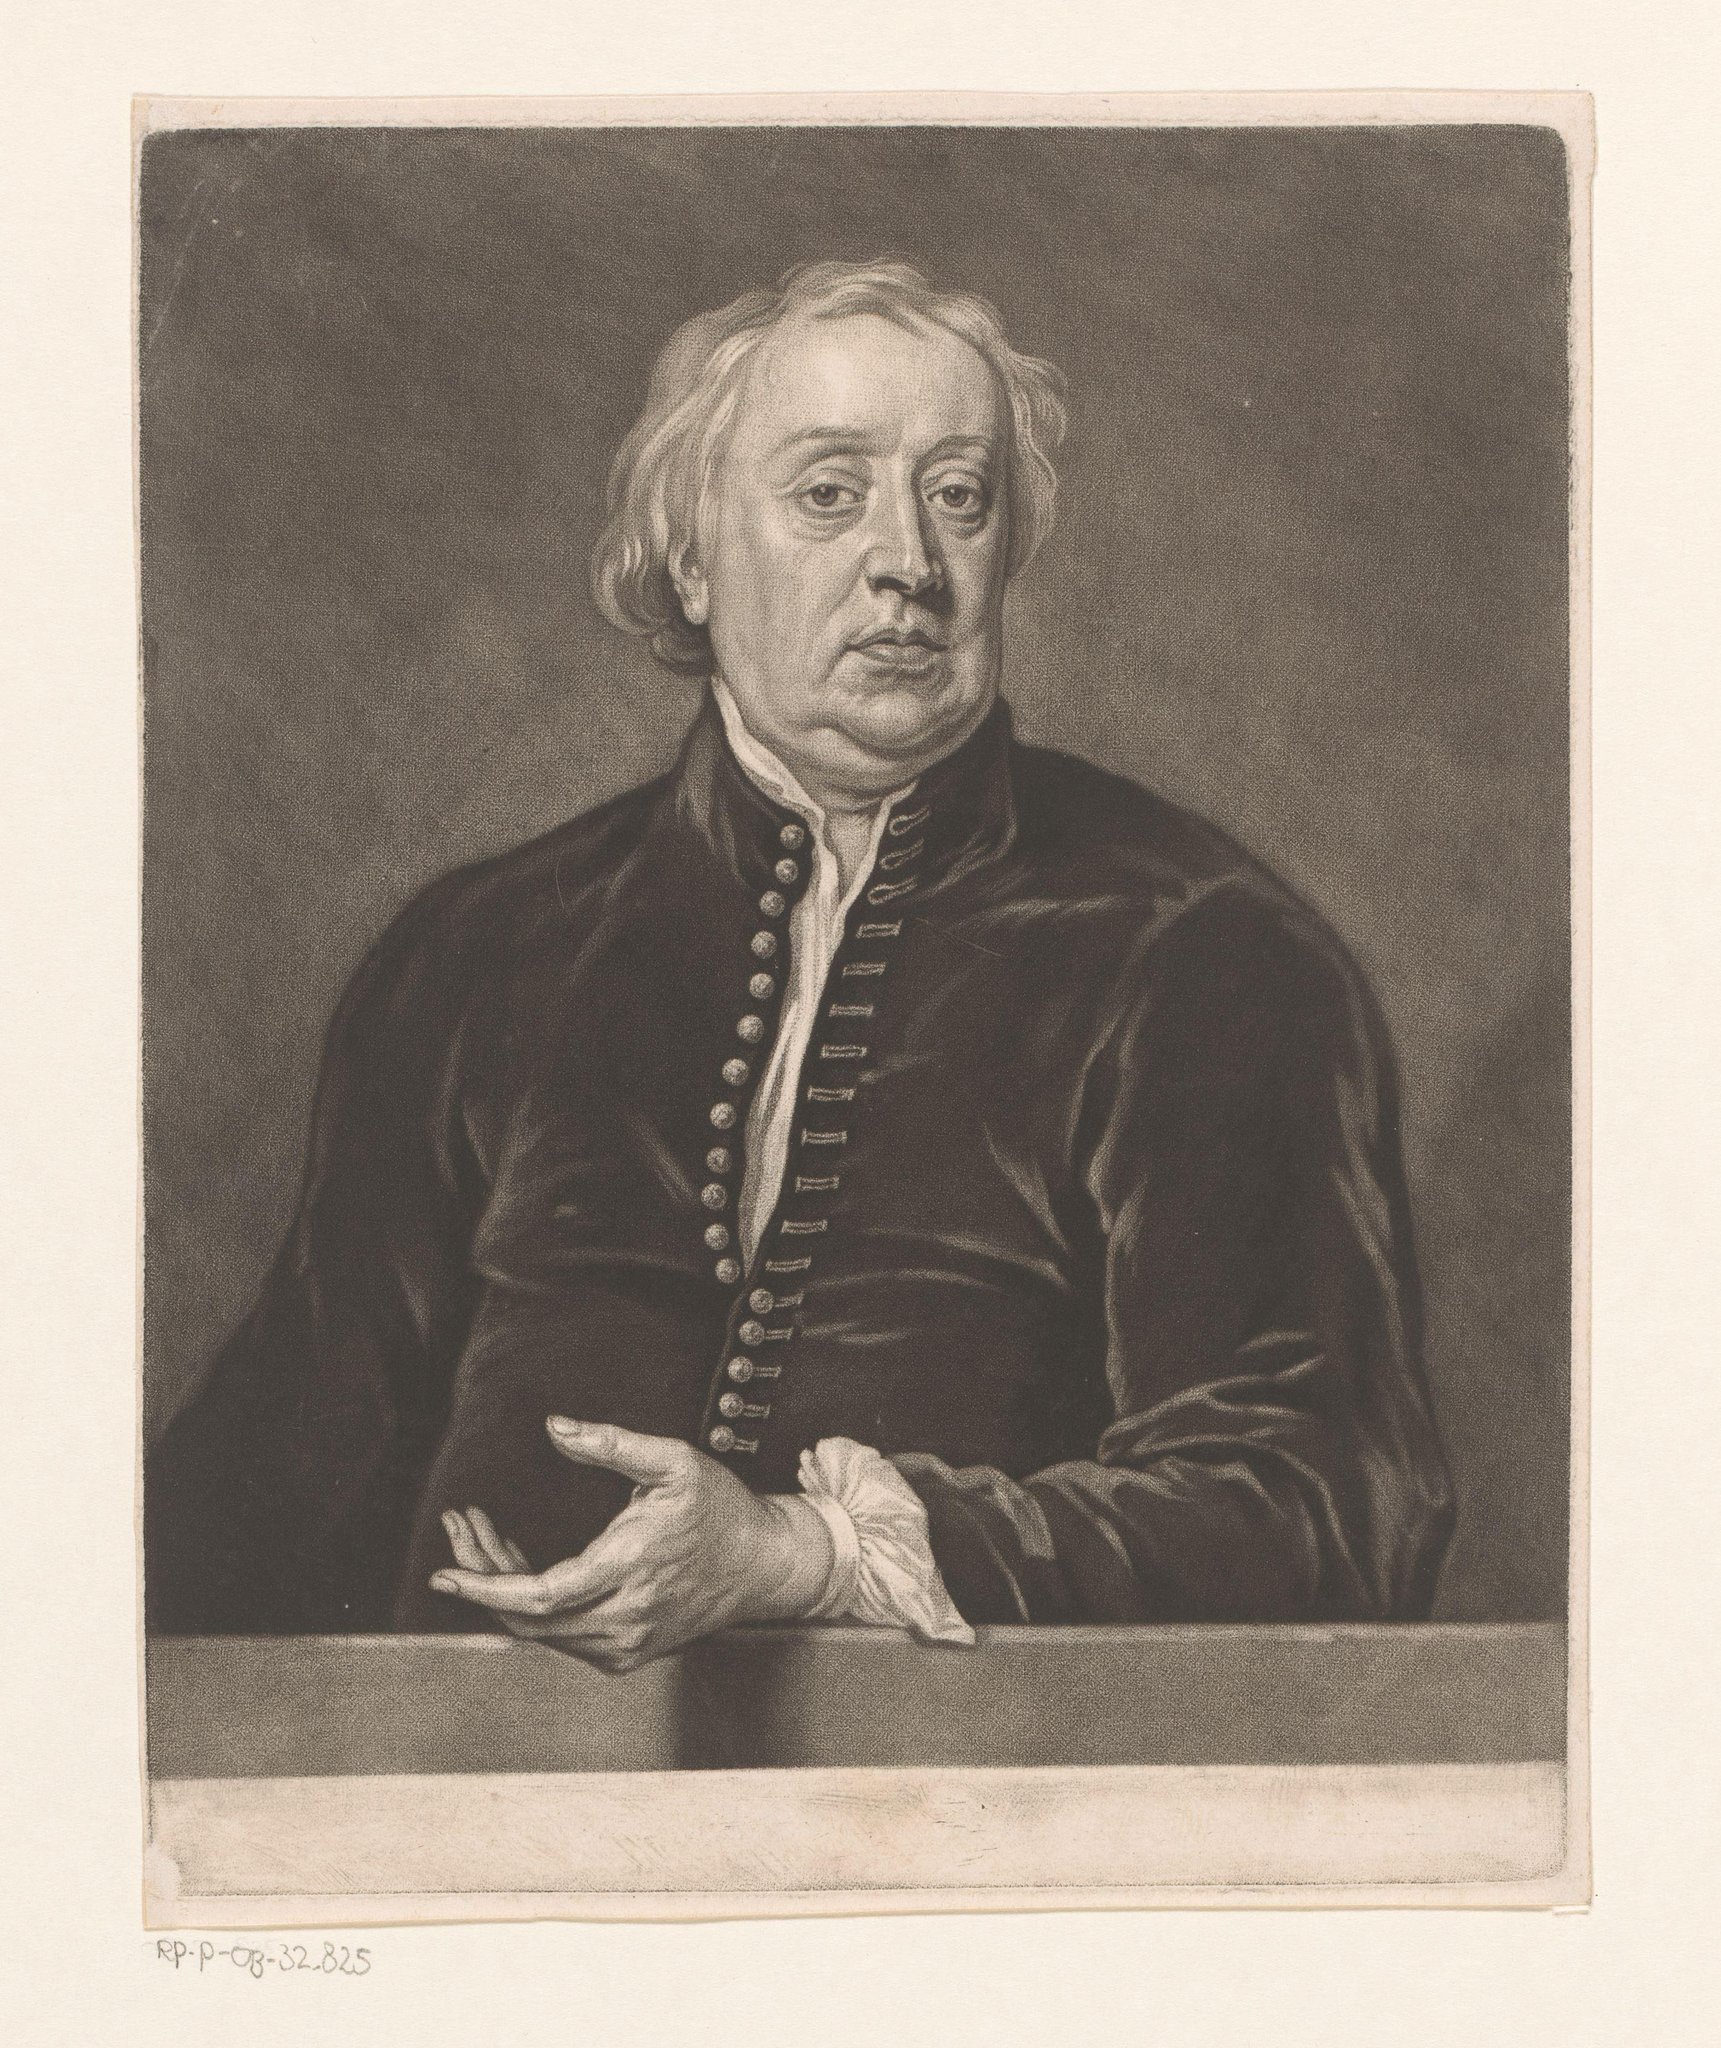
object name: print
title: Portret van William Richards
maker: john smith (prentmaker/ uitgever)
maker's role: print maker, publisher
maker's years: 1652-1743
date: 1662-1742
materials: paper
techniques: mezzotint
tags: historical persons, portrait of a writer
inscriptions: collector's mark: Lugt 240